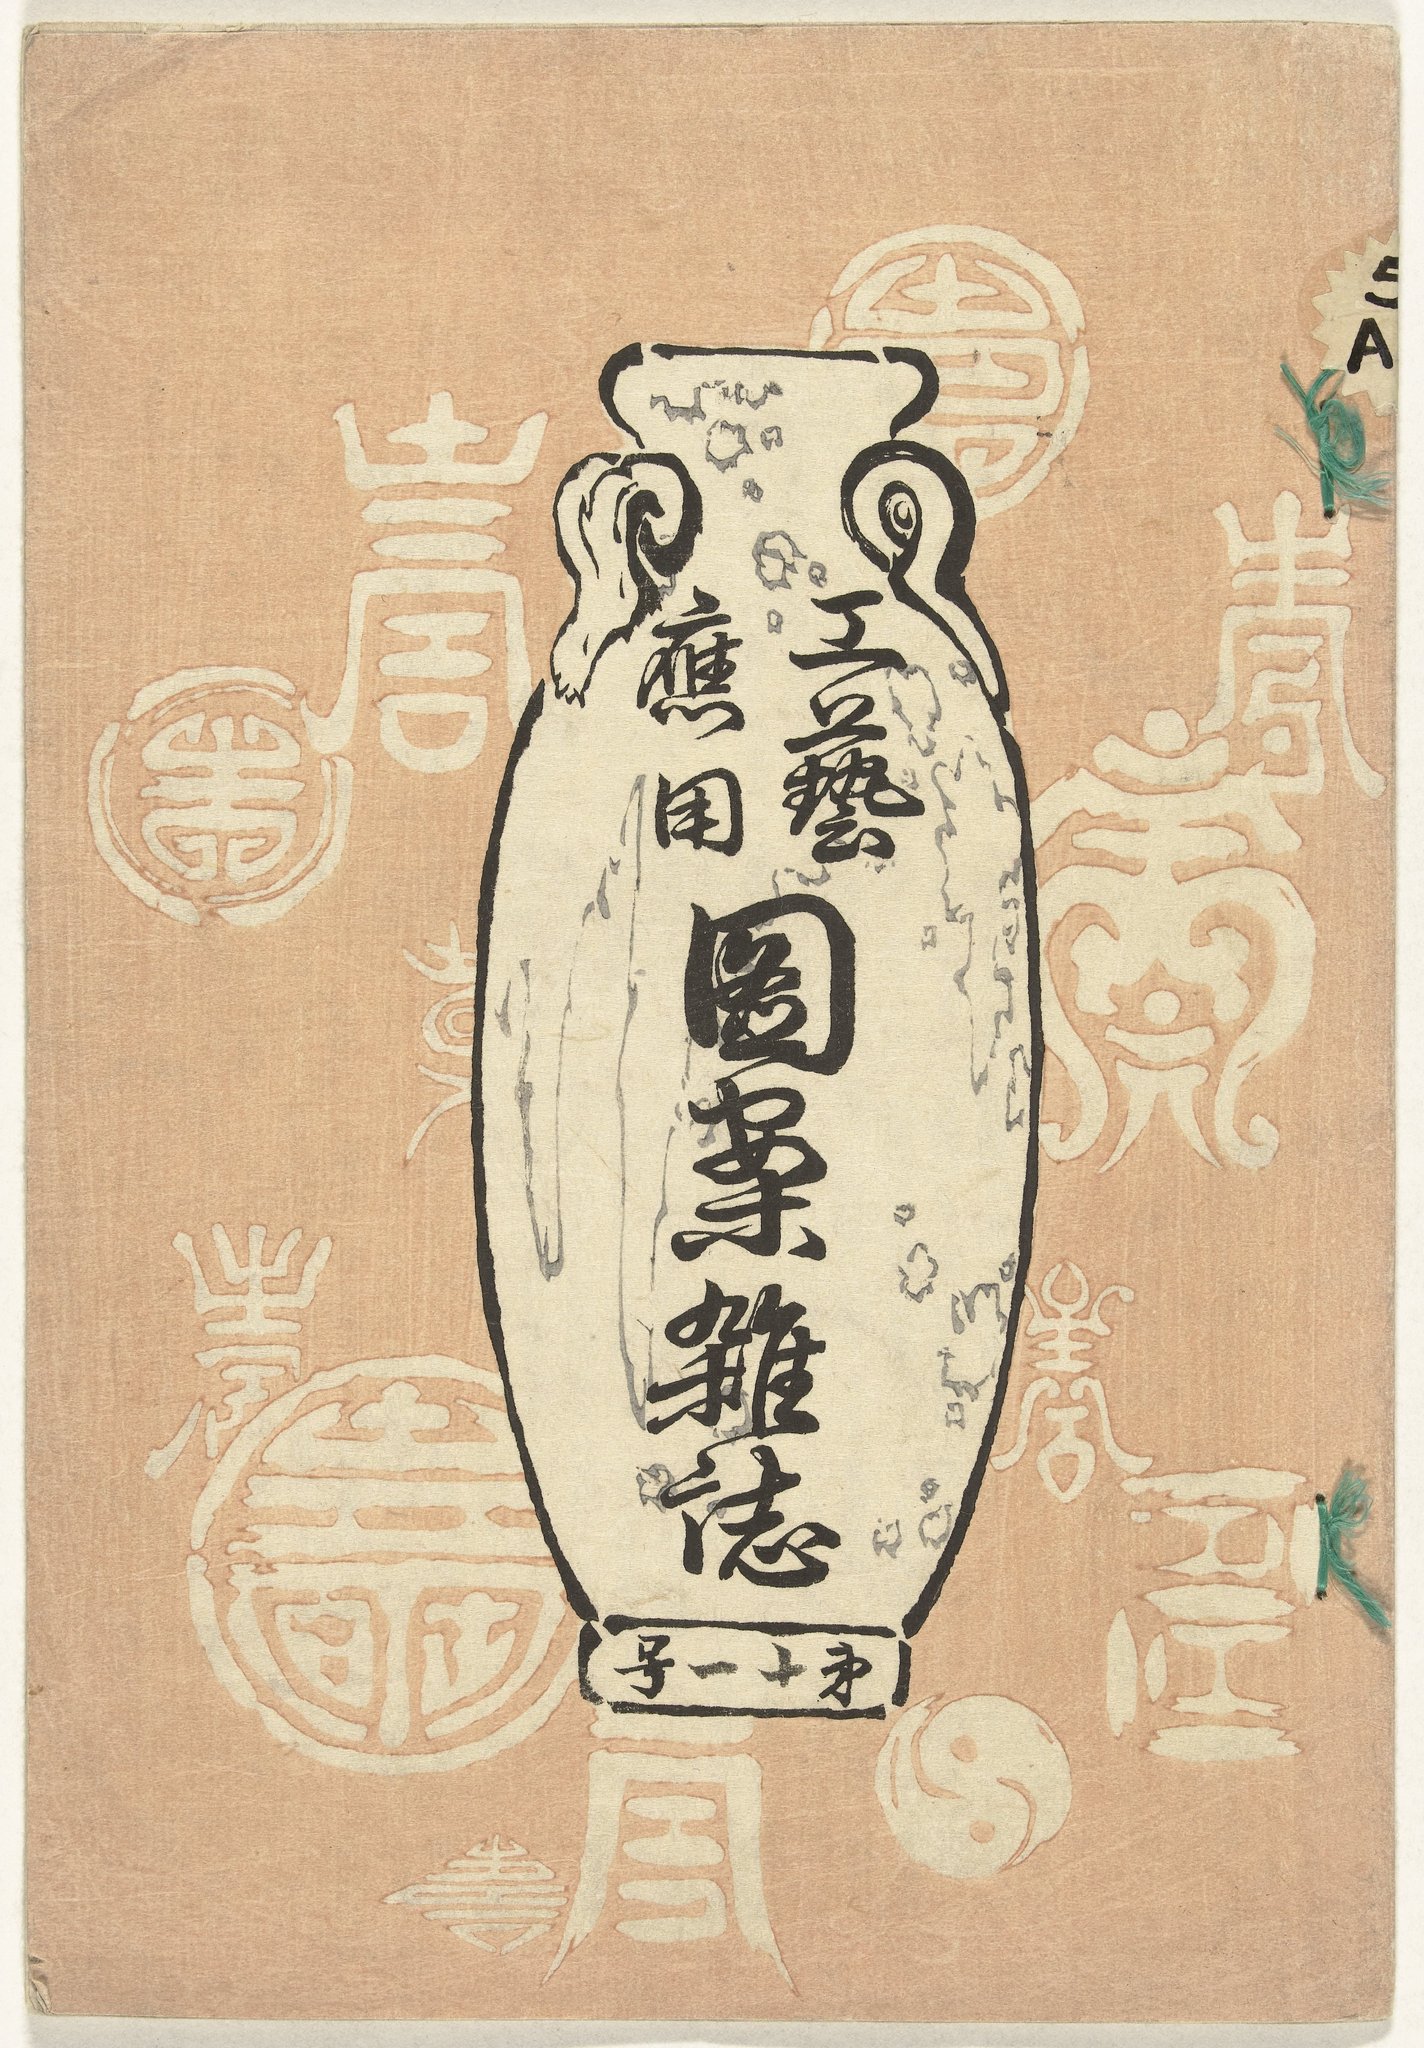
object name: magazine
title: Kogei oyo zuan zasshi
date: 1890-1900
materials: paper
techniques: woodcut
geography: tokyo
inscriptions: collector's mark: ‘Rijksschool voor kunstnijverheid’ Lugt 3937, collector's mark: Lugt 2228